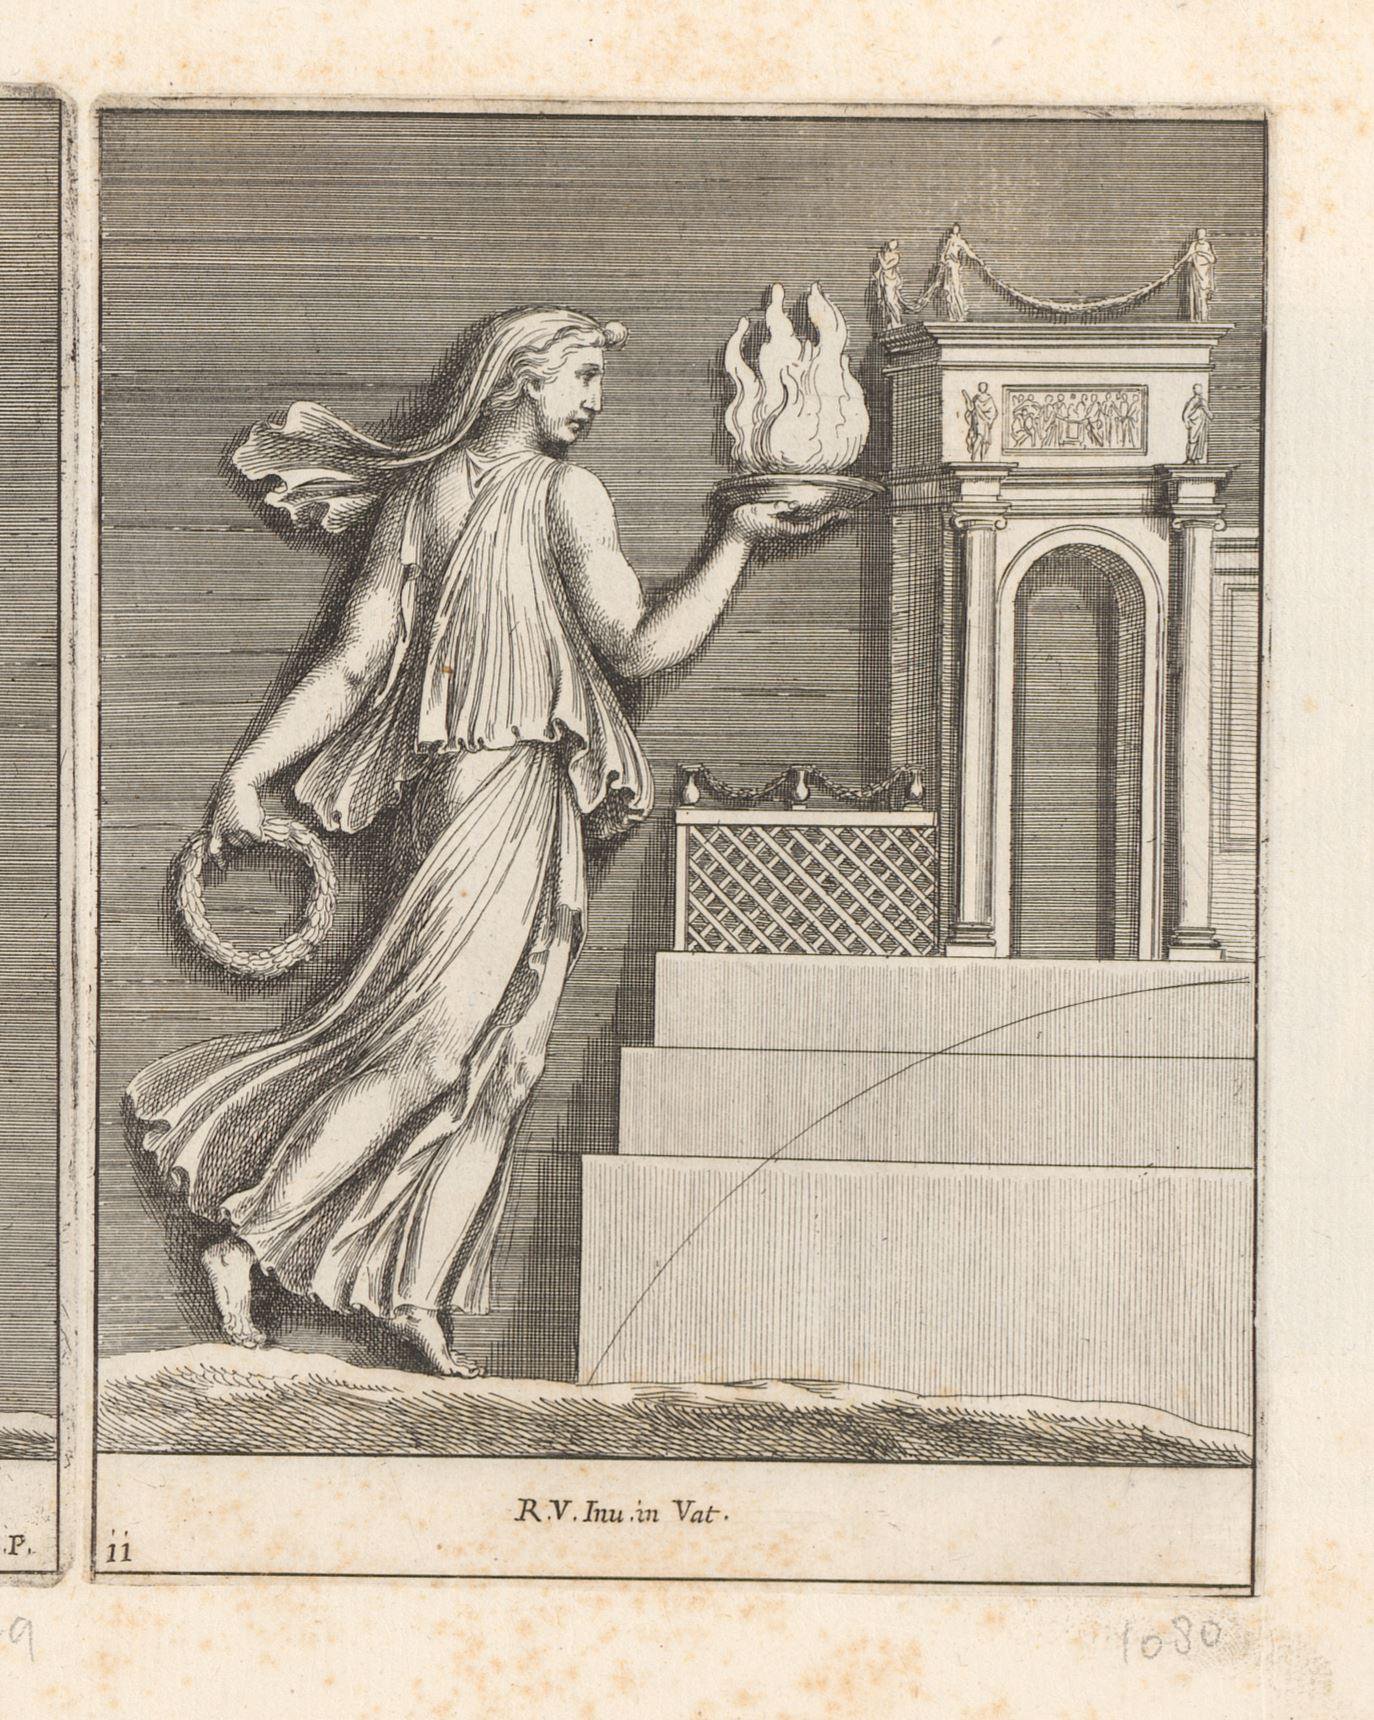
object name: album leaf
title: Offerritueel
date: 1645-1700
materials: paper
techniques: engraving, etching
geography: rome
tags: sacrifice ~ roman religion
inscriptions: number: ‘41’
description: Een vrouwenfiguur maakt een offer. In haar handen een schaal met vuur en een krans. Prent maakt deel uit van een album.